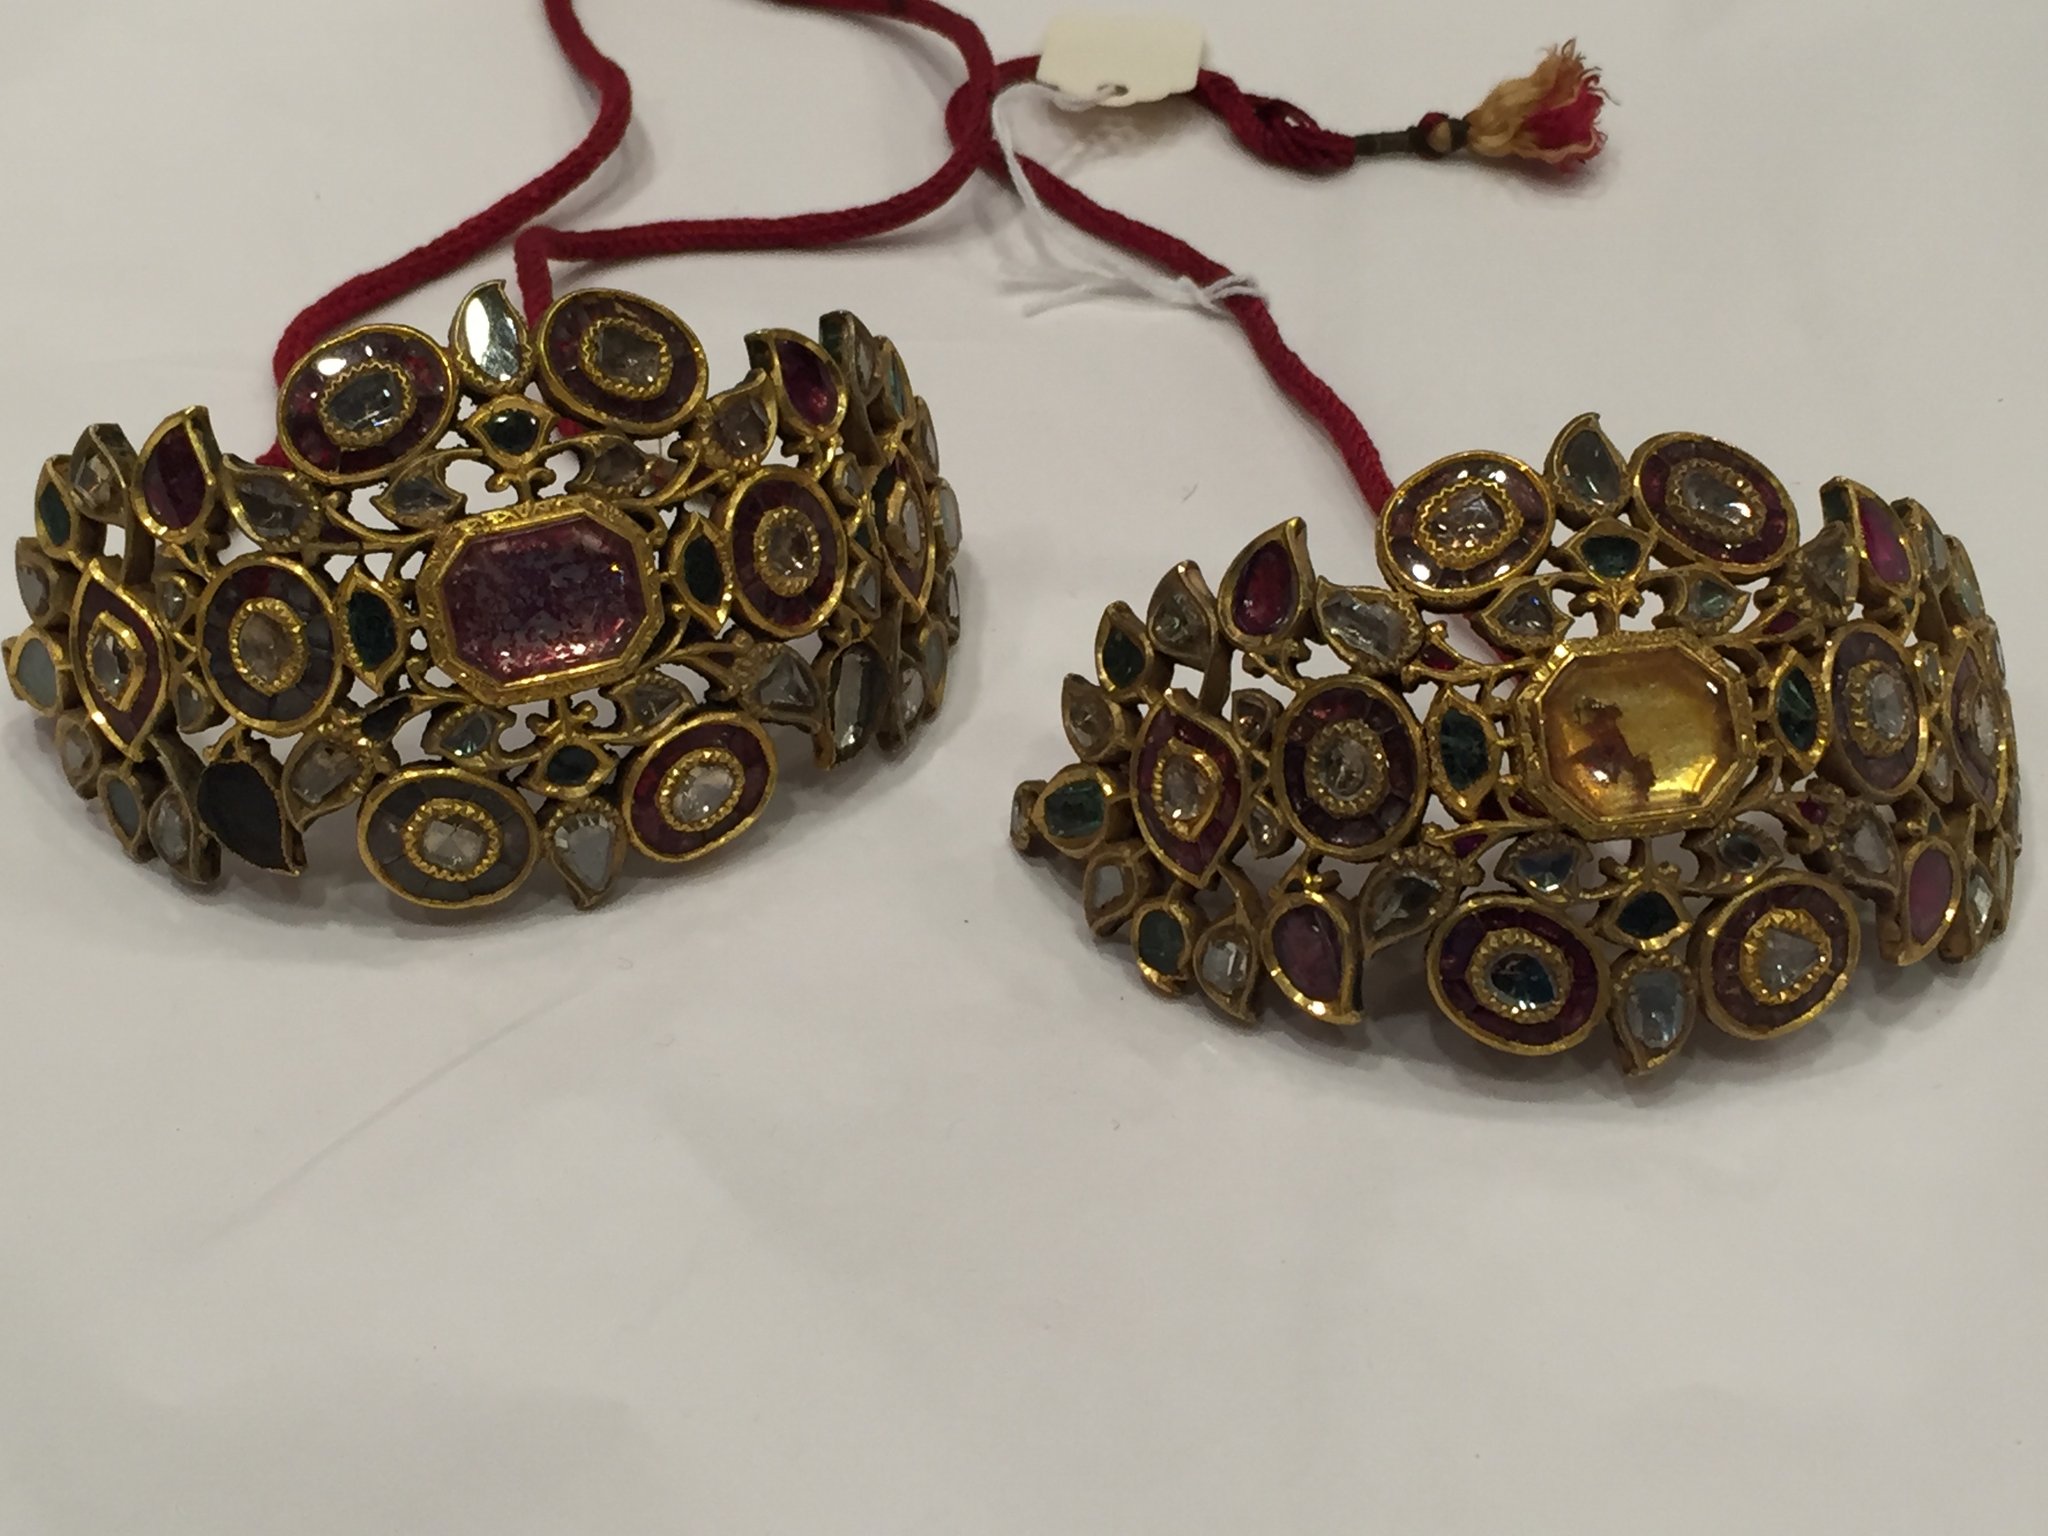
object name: armband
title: Armband (Bazuband), One of a Pair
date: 1801-1900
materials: enamel, gold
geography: india